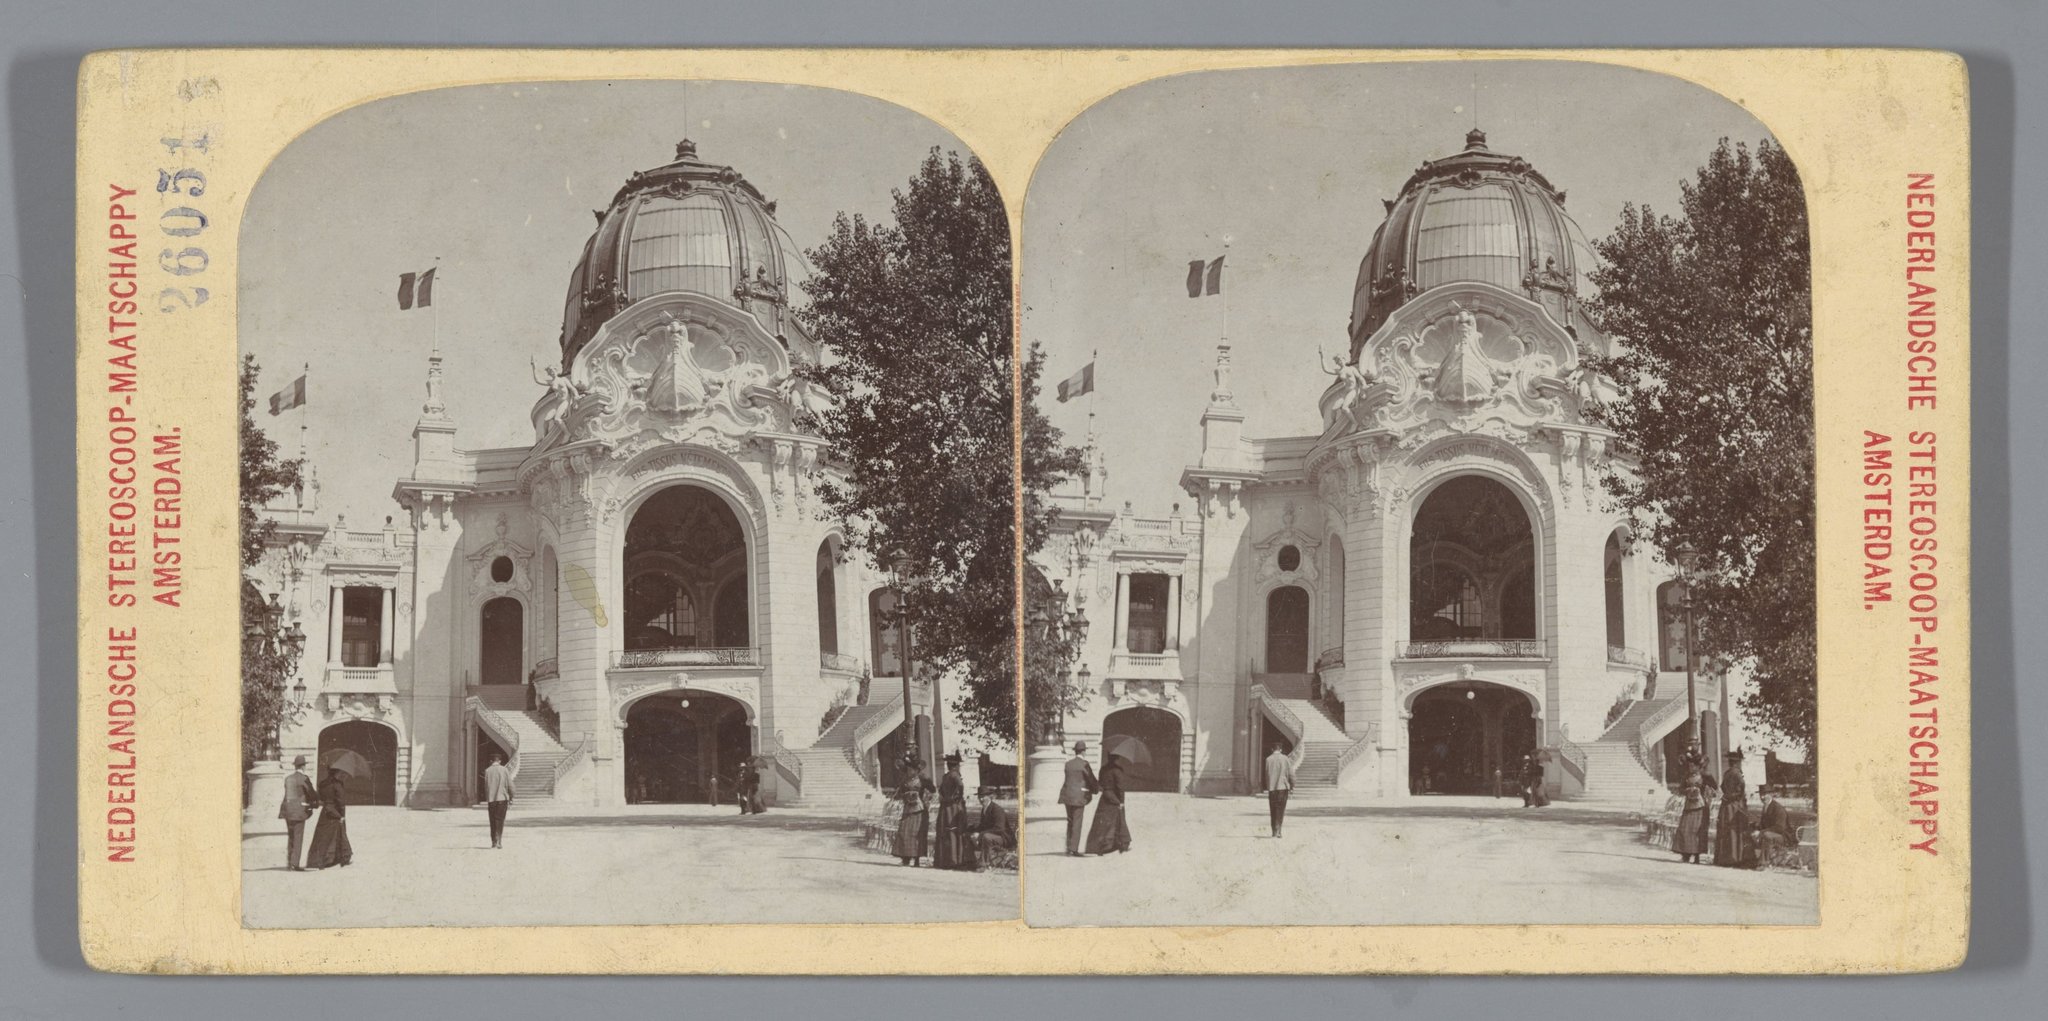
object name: stereograph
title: Modepaviljoen op de Wereldtentoonstelling van 1900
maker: j.g. beers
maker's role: fotograaf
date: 1900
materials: paper, cardboard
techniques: gelatin silver print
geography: amsterdam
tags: world fair, world exhibition, paris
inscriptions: inscription: ‘Parijs tentoonstelling 1900’, number: ‘26051’